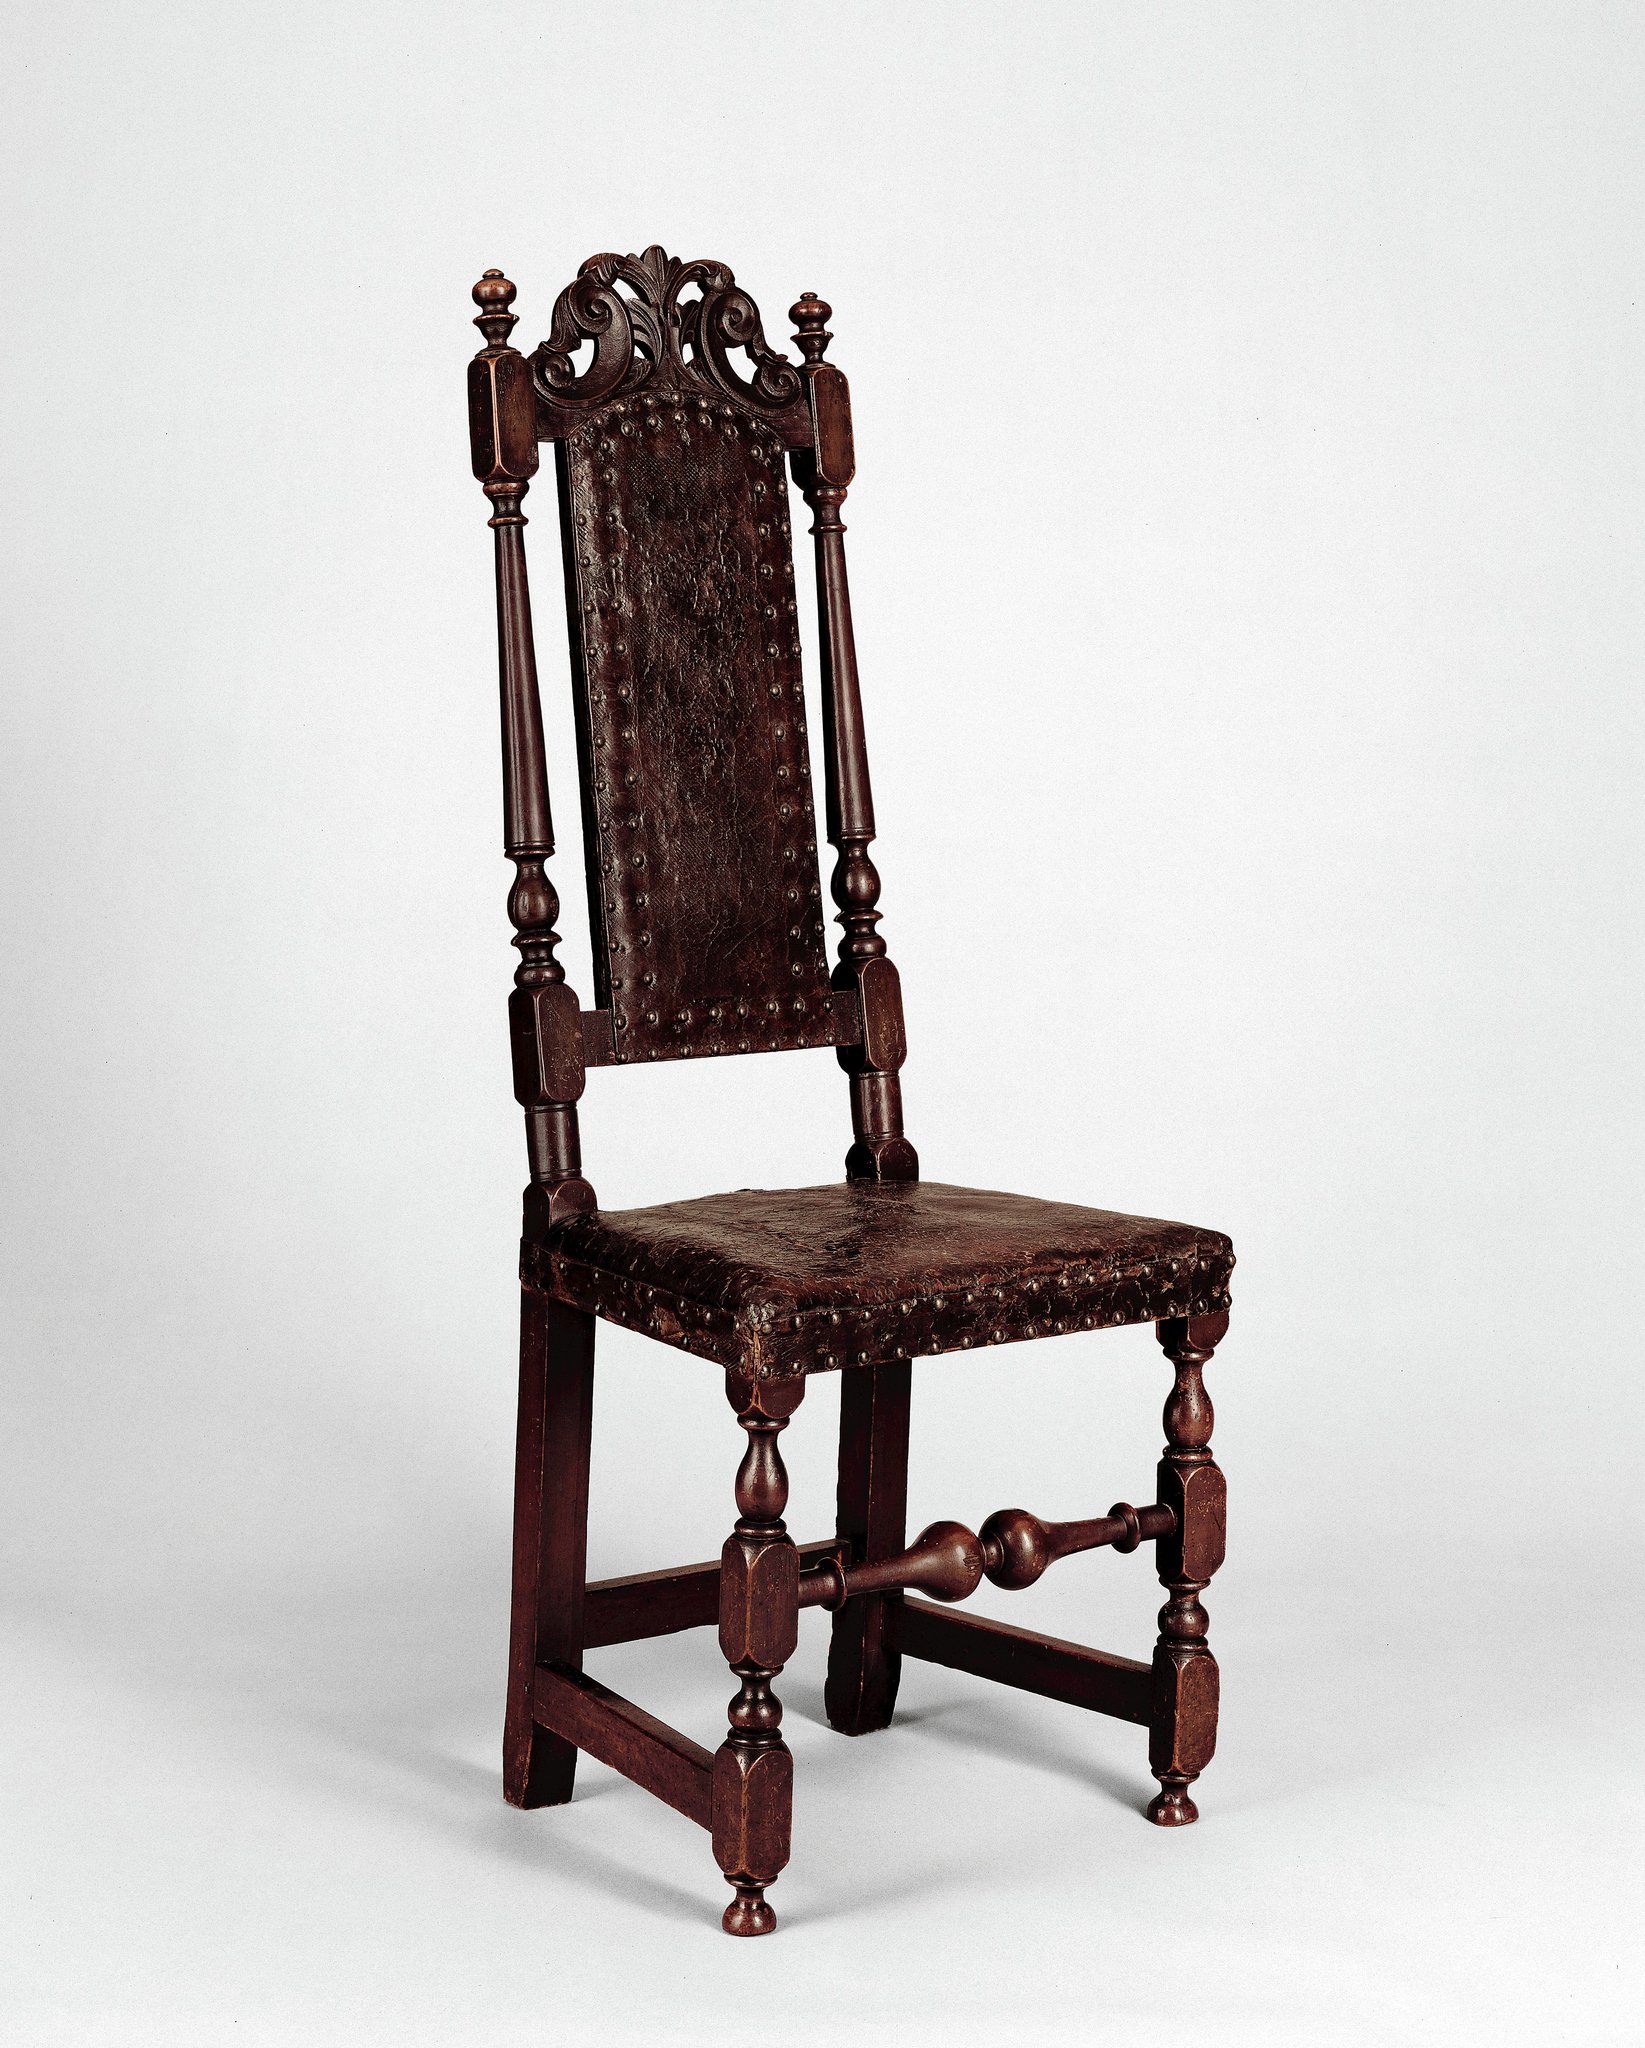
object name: side chair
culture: american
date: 1700-1720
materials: wood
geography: united states